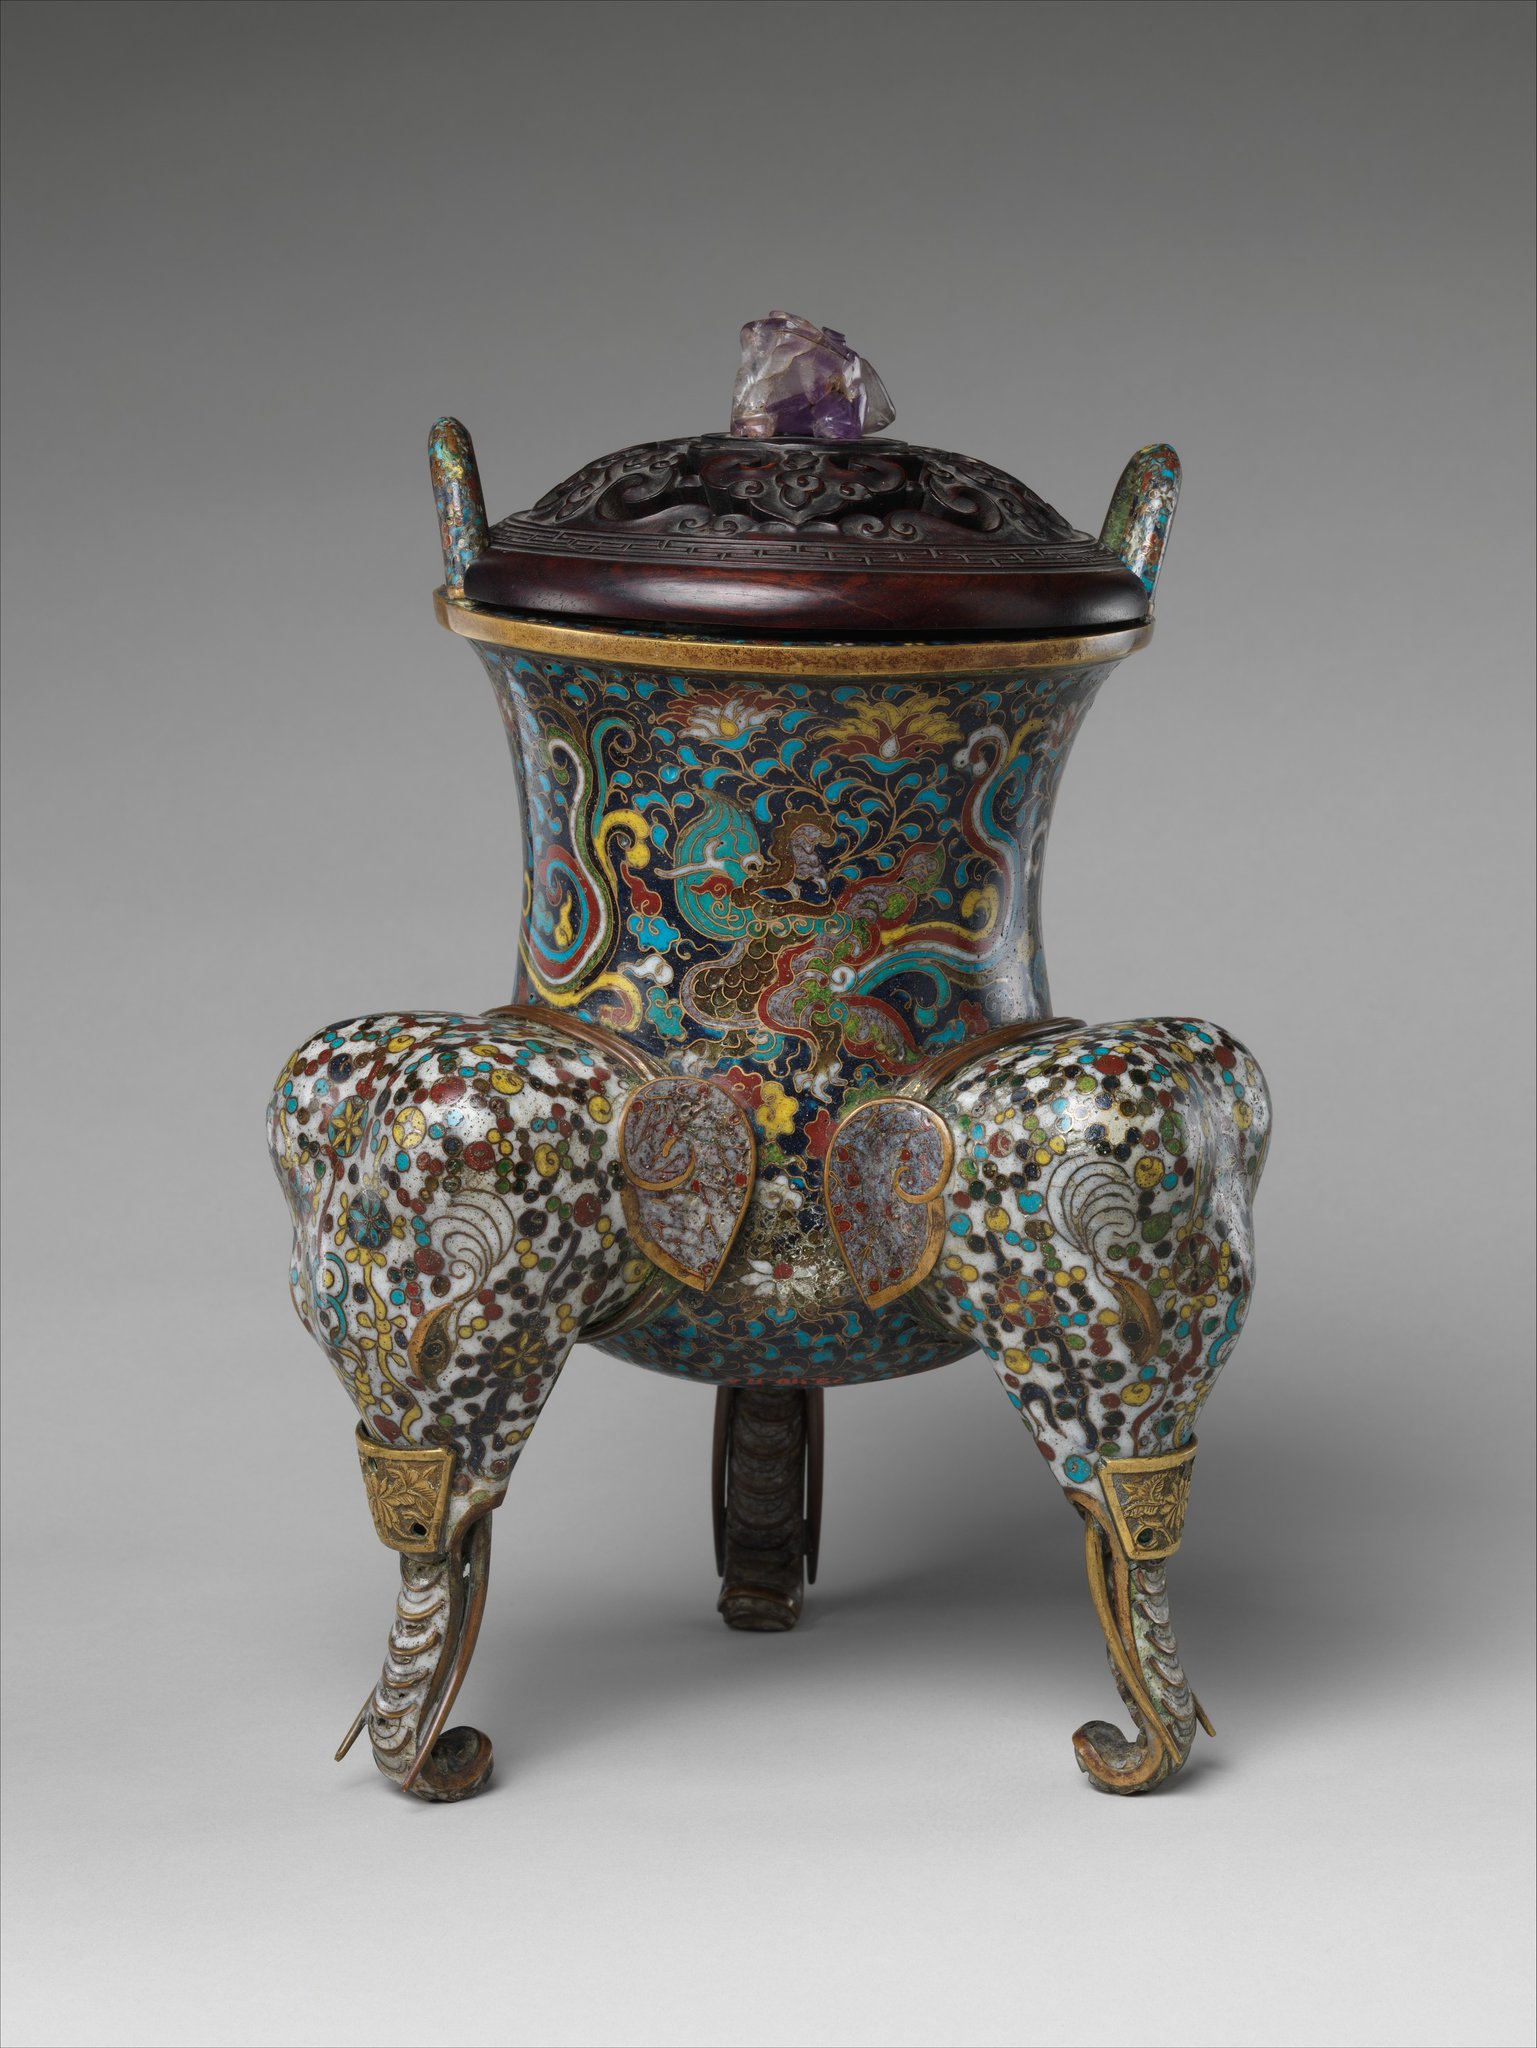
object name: incense burner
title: Tripod incense burner with makara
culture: chinese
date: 1501-1600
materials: enamel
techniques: enamel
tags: dragons,elephants,flowers